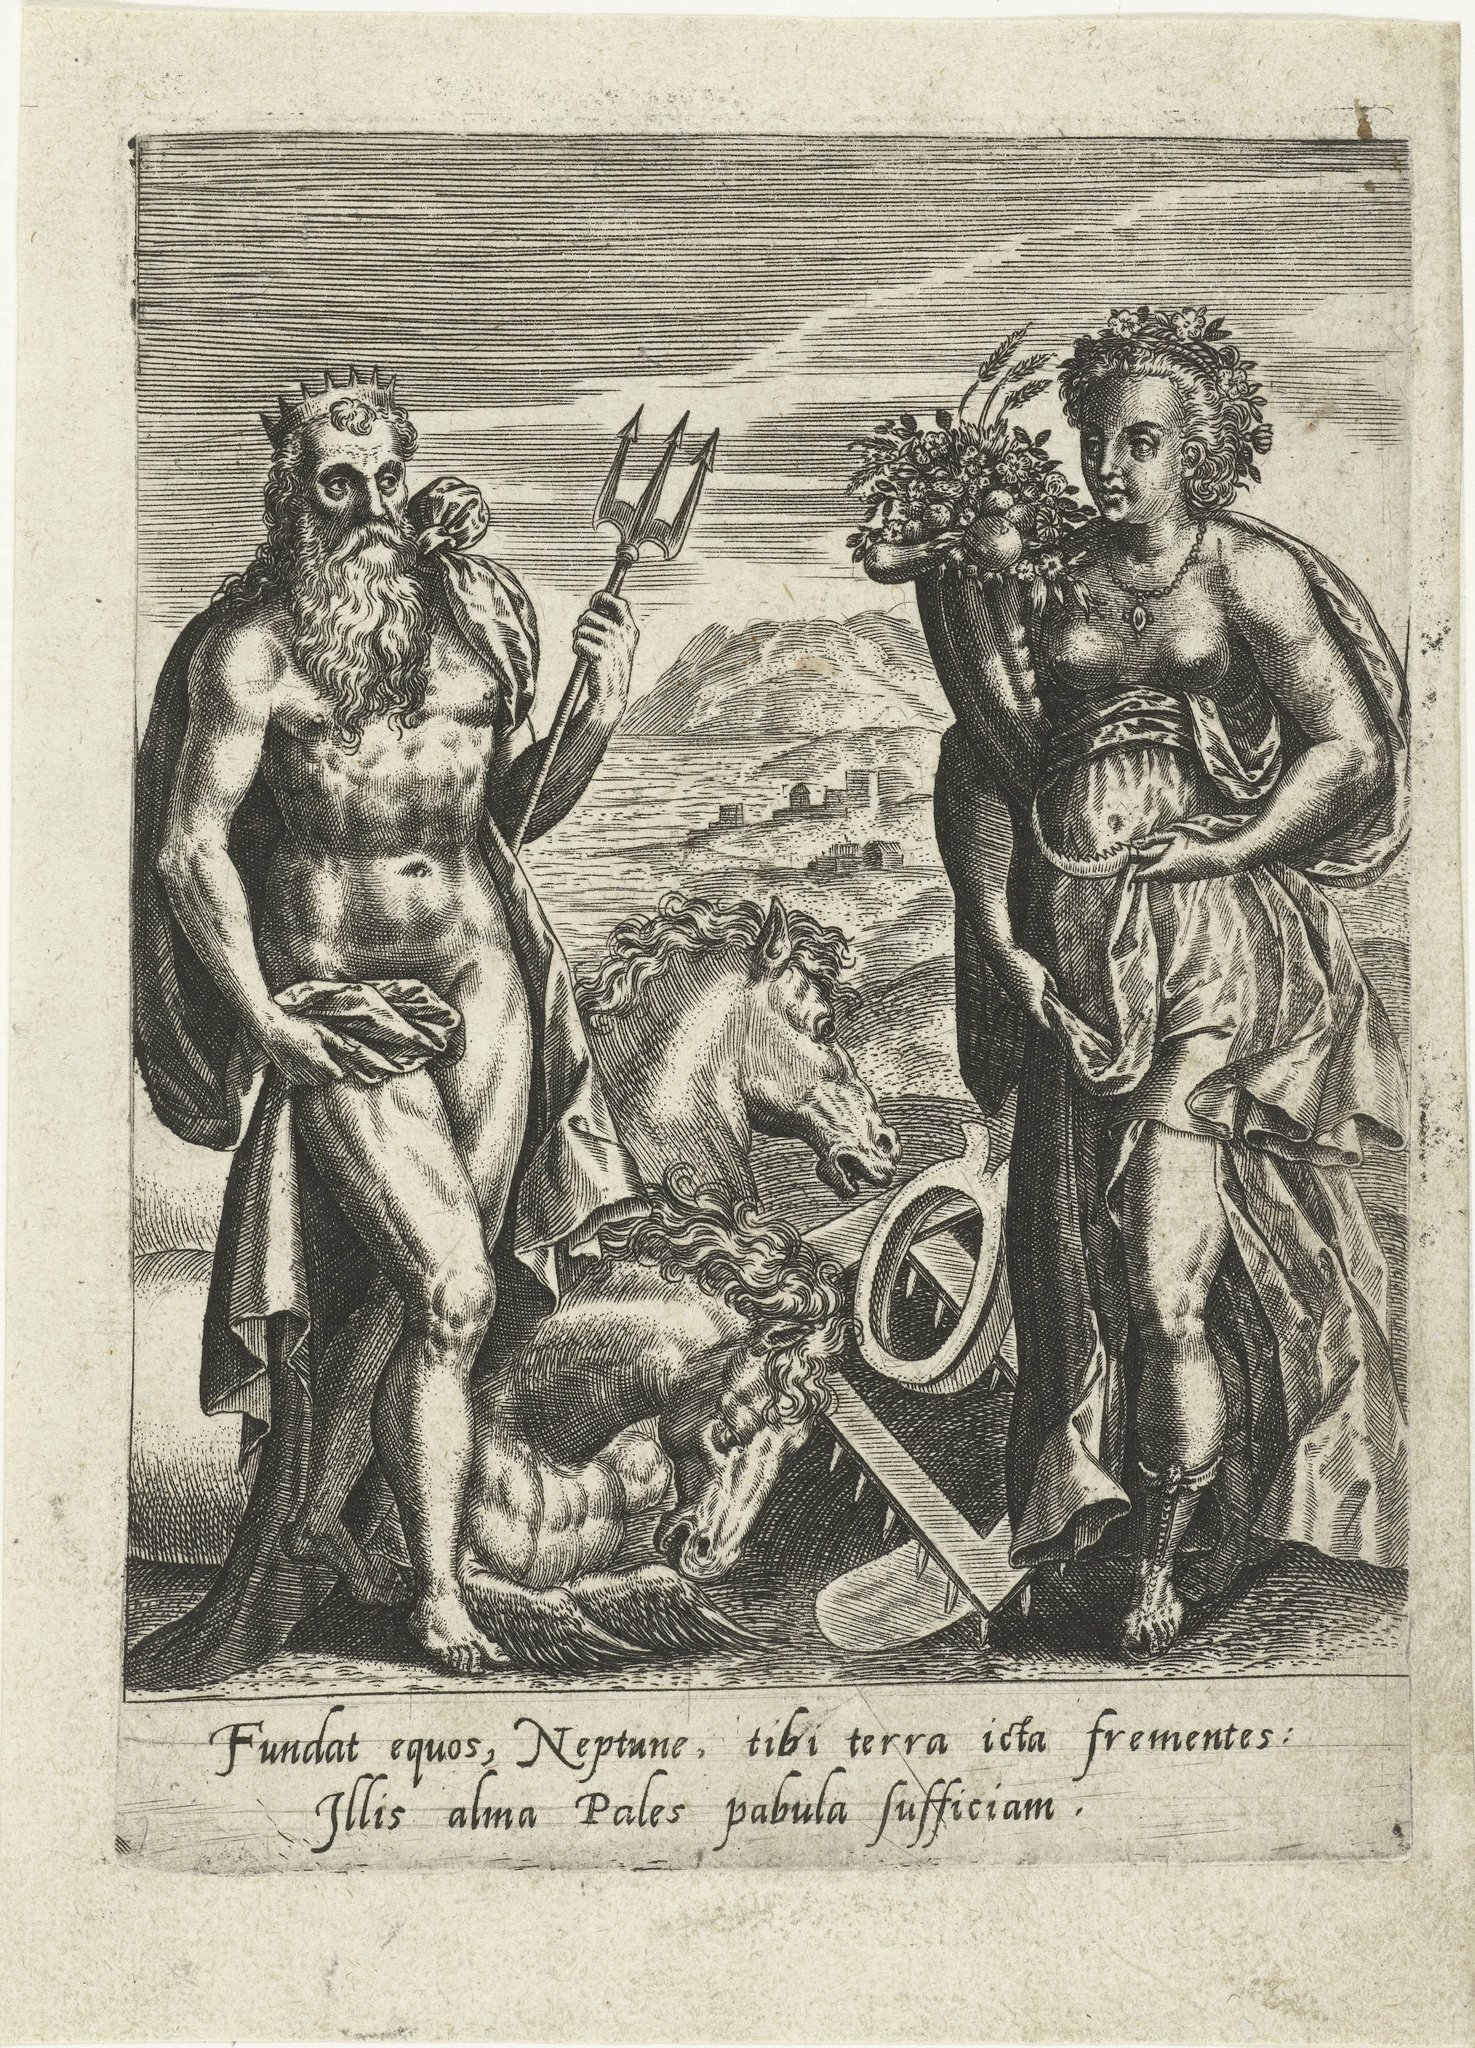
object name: book illustration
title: Neptunus en Ceres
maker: abraham de bruyn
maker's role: print maker, publisher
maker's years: 1540-1587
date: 1577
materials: paper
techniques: engraving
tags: (story of) neptune (poseidon), (story of) ceres (demeter), 'cornucopia', horn of plenty, sea-horse, hippocamp, 'hippocampus', (horse/fish) (mythological hybrid monster), agricultural implements, attributes of neptune: trident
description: Neptunus staat links van de prent en heeft zijn drietand in zijn linkerhand. Aan zijn voeten liggen twee zeepaarden. Ceres staat rechts en houdt de cornucopia in haar hand. Aan haar voeten ligt landbouwgereedschap. Het achterliggend landschap toon een kustlijn. De prent heeft een Latijns onderschrift.